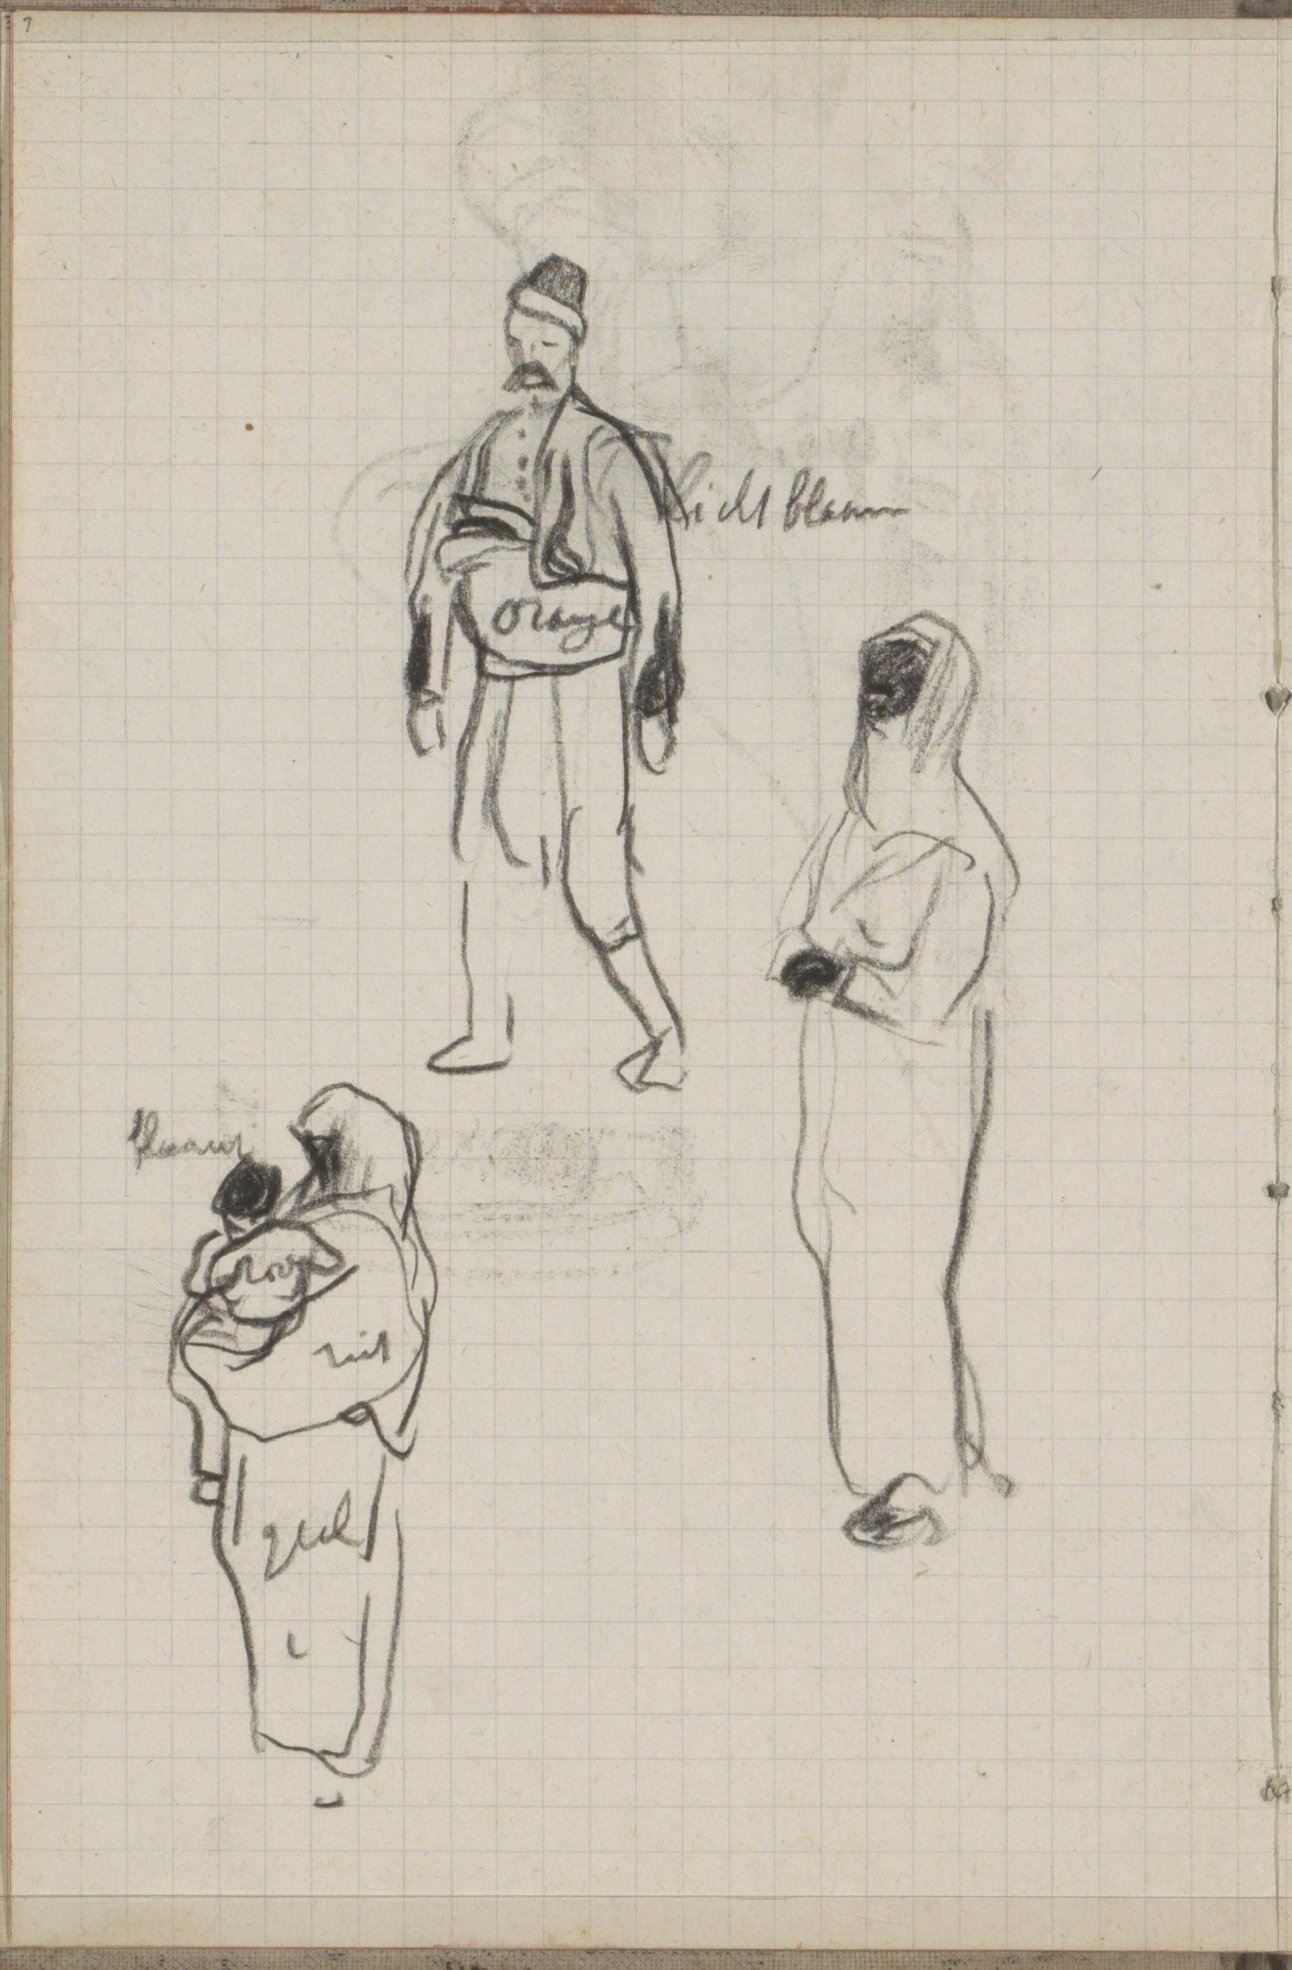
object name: sketchbook leaf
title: Drie staande figuren in oosterse kleding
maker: marius bauer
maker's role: draughtsman, print maker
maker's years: 1867-1932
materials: chalk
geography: istanbul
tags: asiatic races and peoples, carrying a child on the hip, astride, standing figure, adult man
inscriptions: kleurnotitie, handgeschreven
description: Waaronder een figuur met een kind op de arm. Pagina 7 uit een schetsboek met 54 bladen